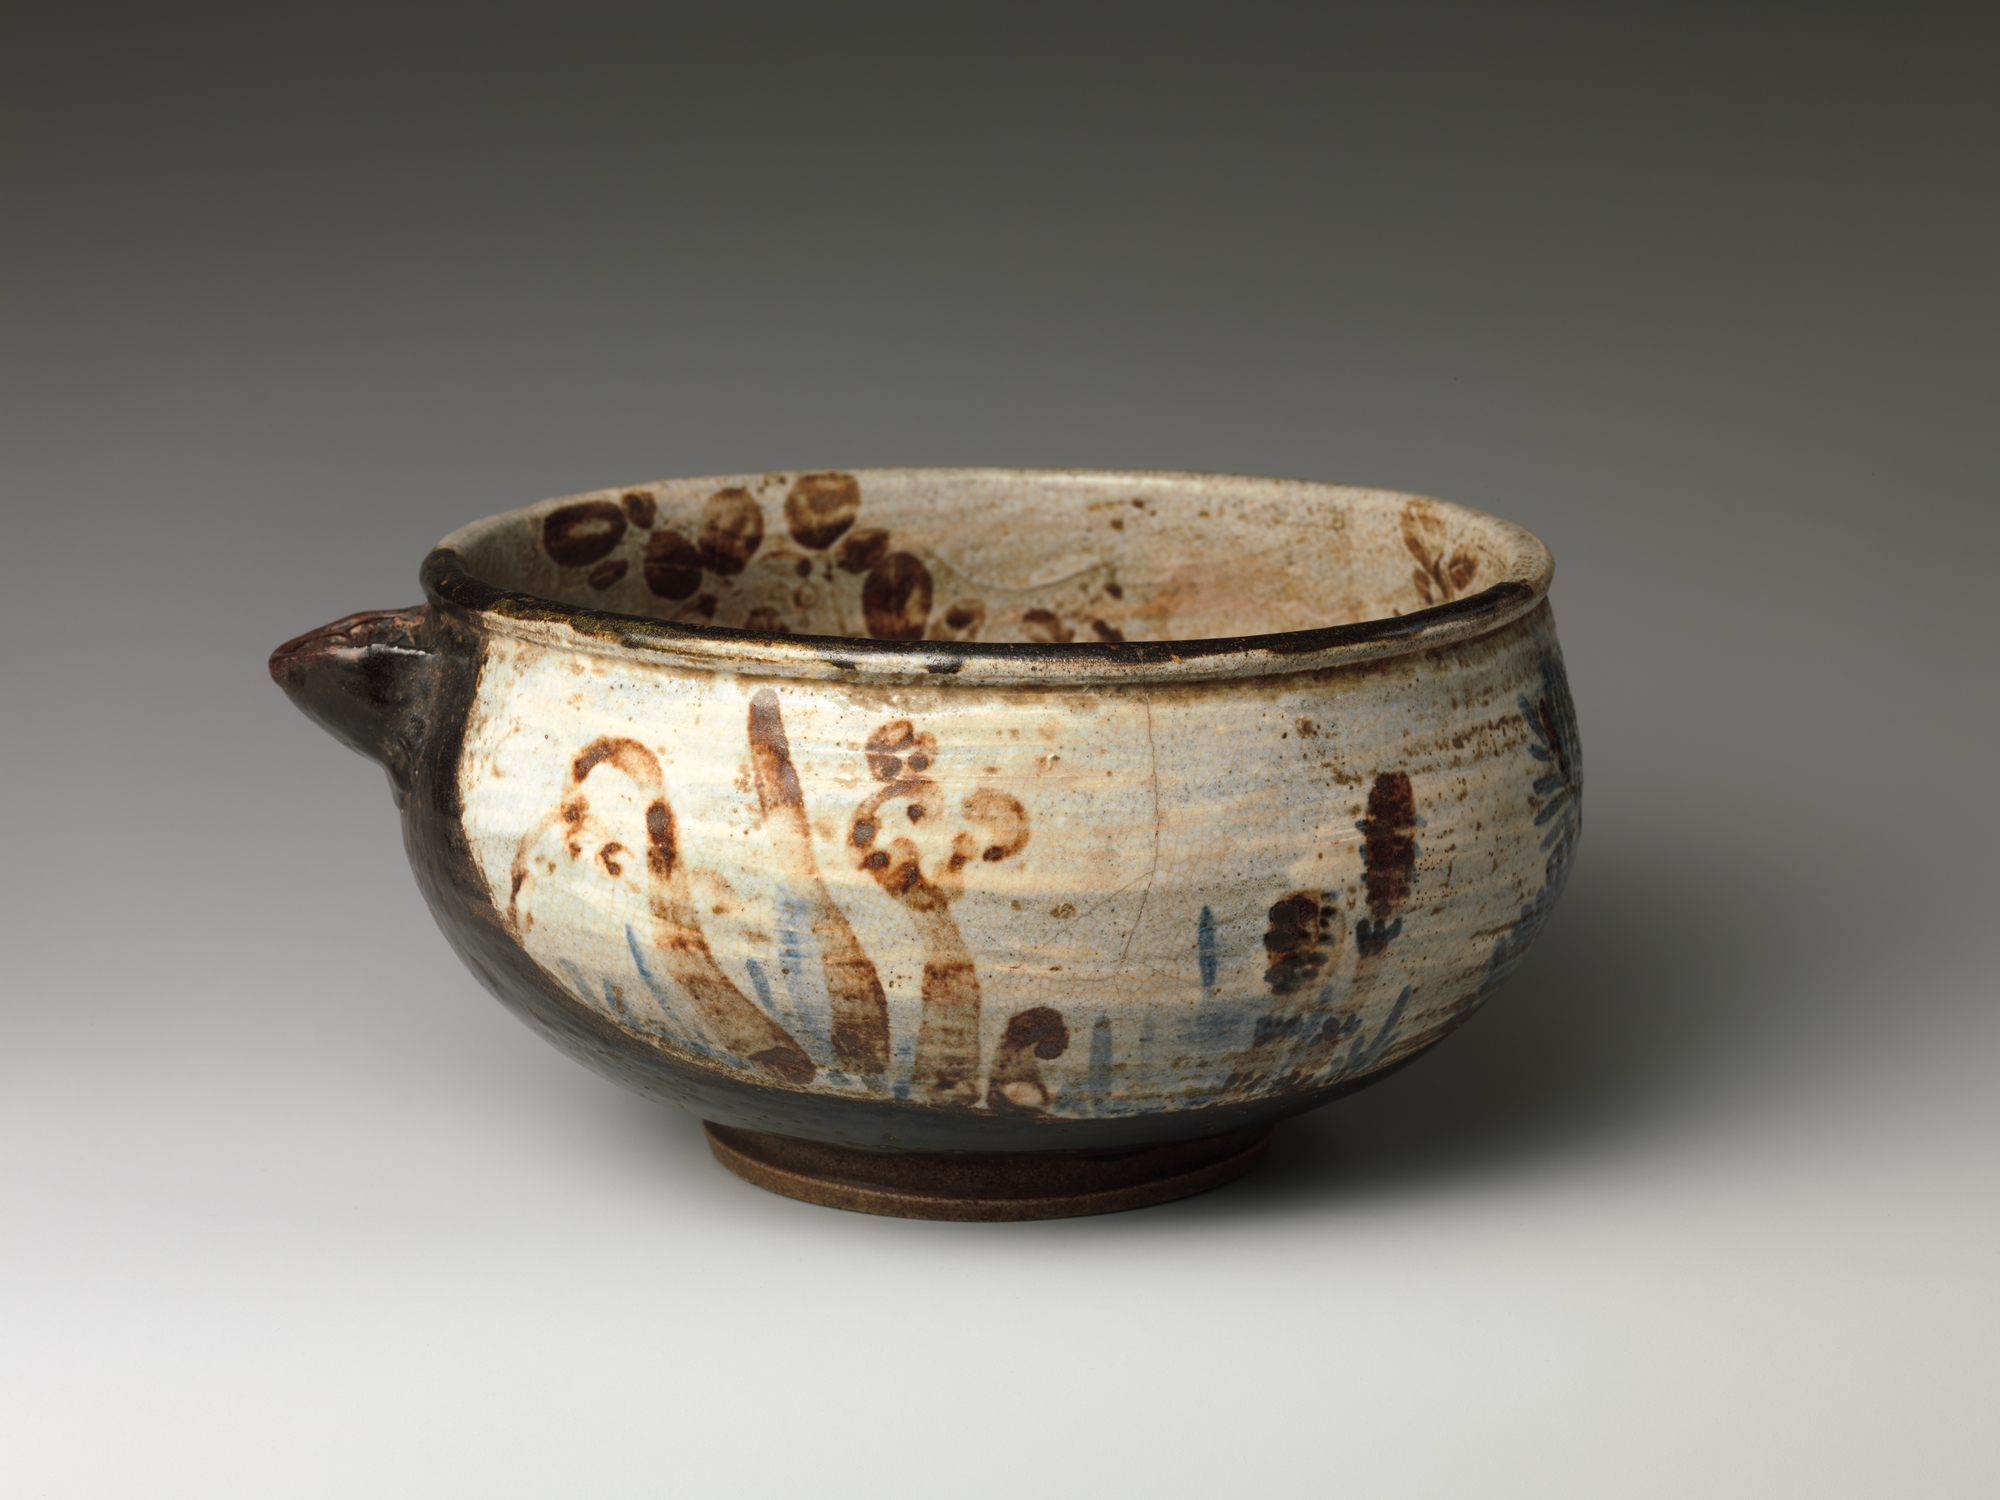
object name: water pot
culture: japanese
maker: ogata kenzan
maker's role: artist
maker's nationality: japanese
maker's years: 1663-1743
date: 1701-1800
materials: clay, glaze